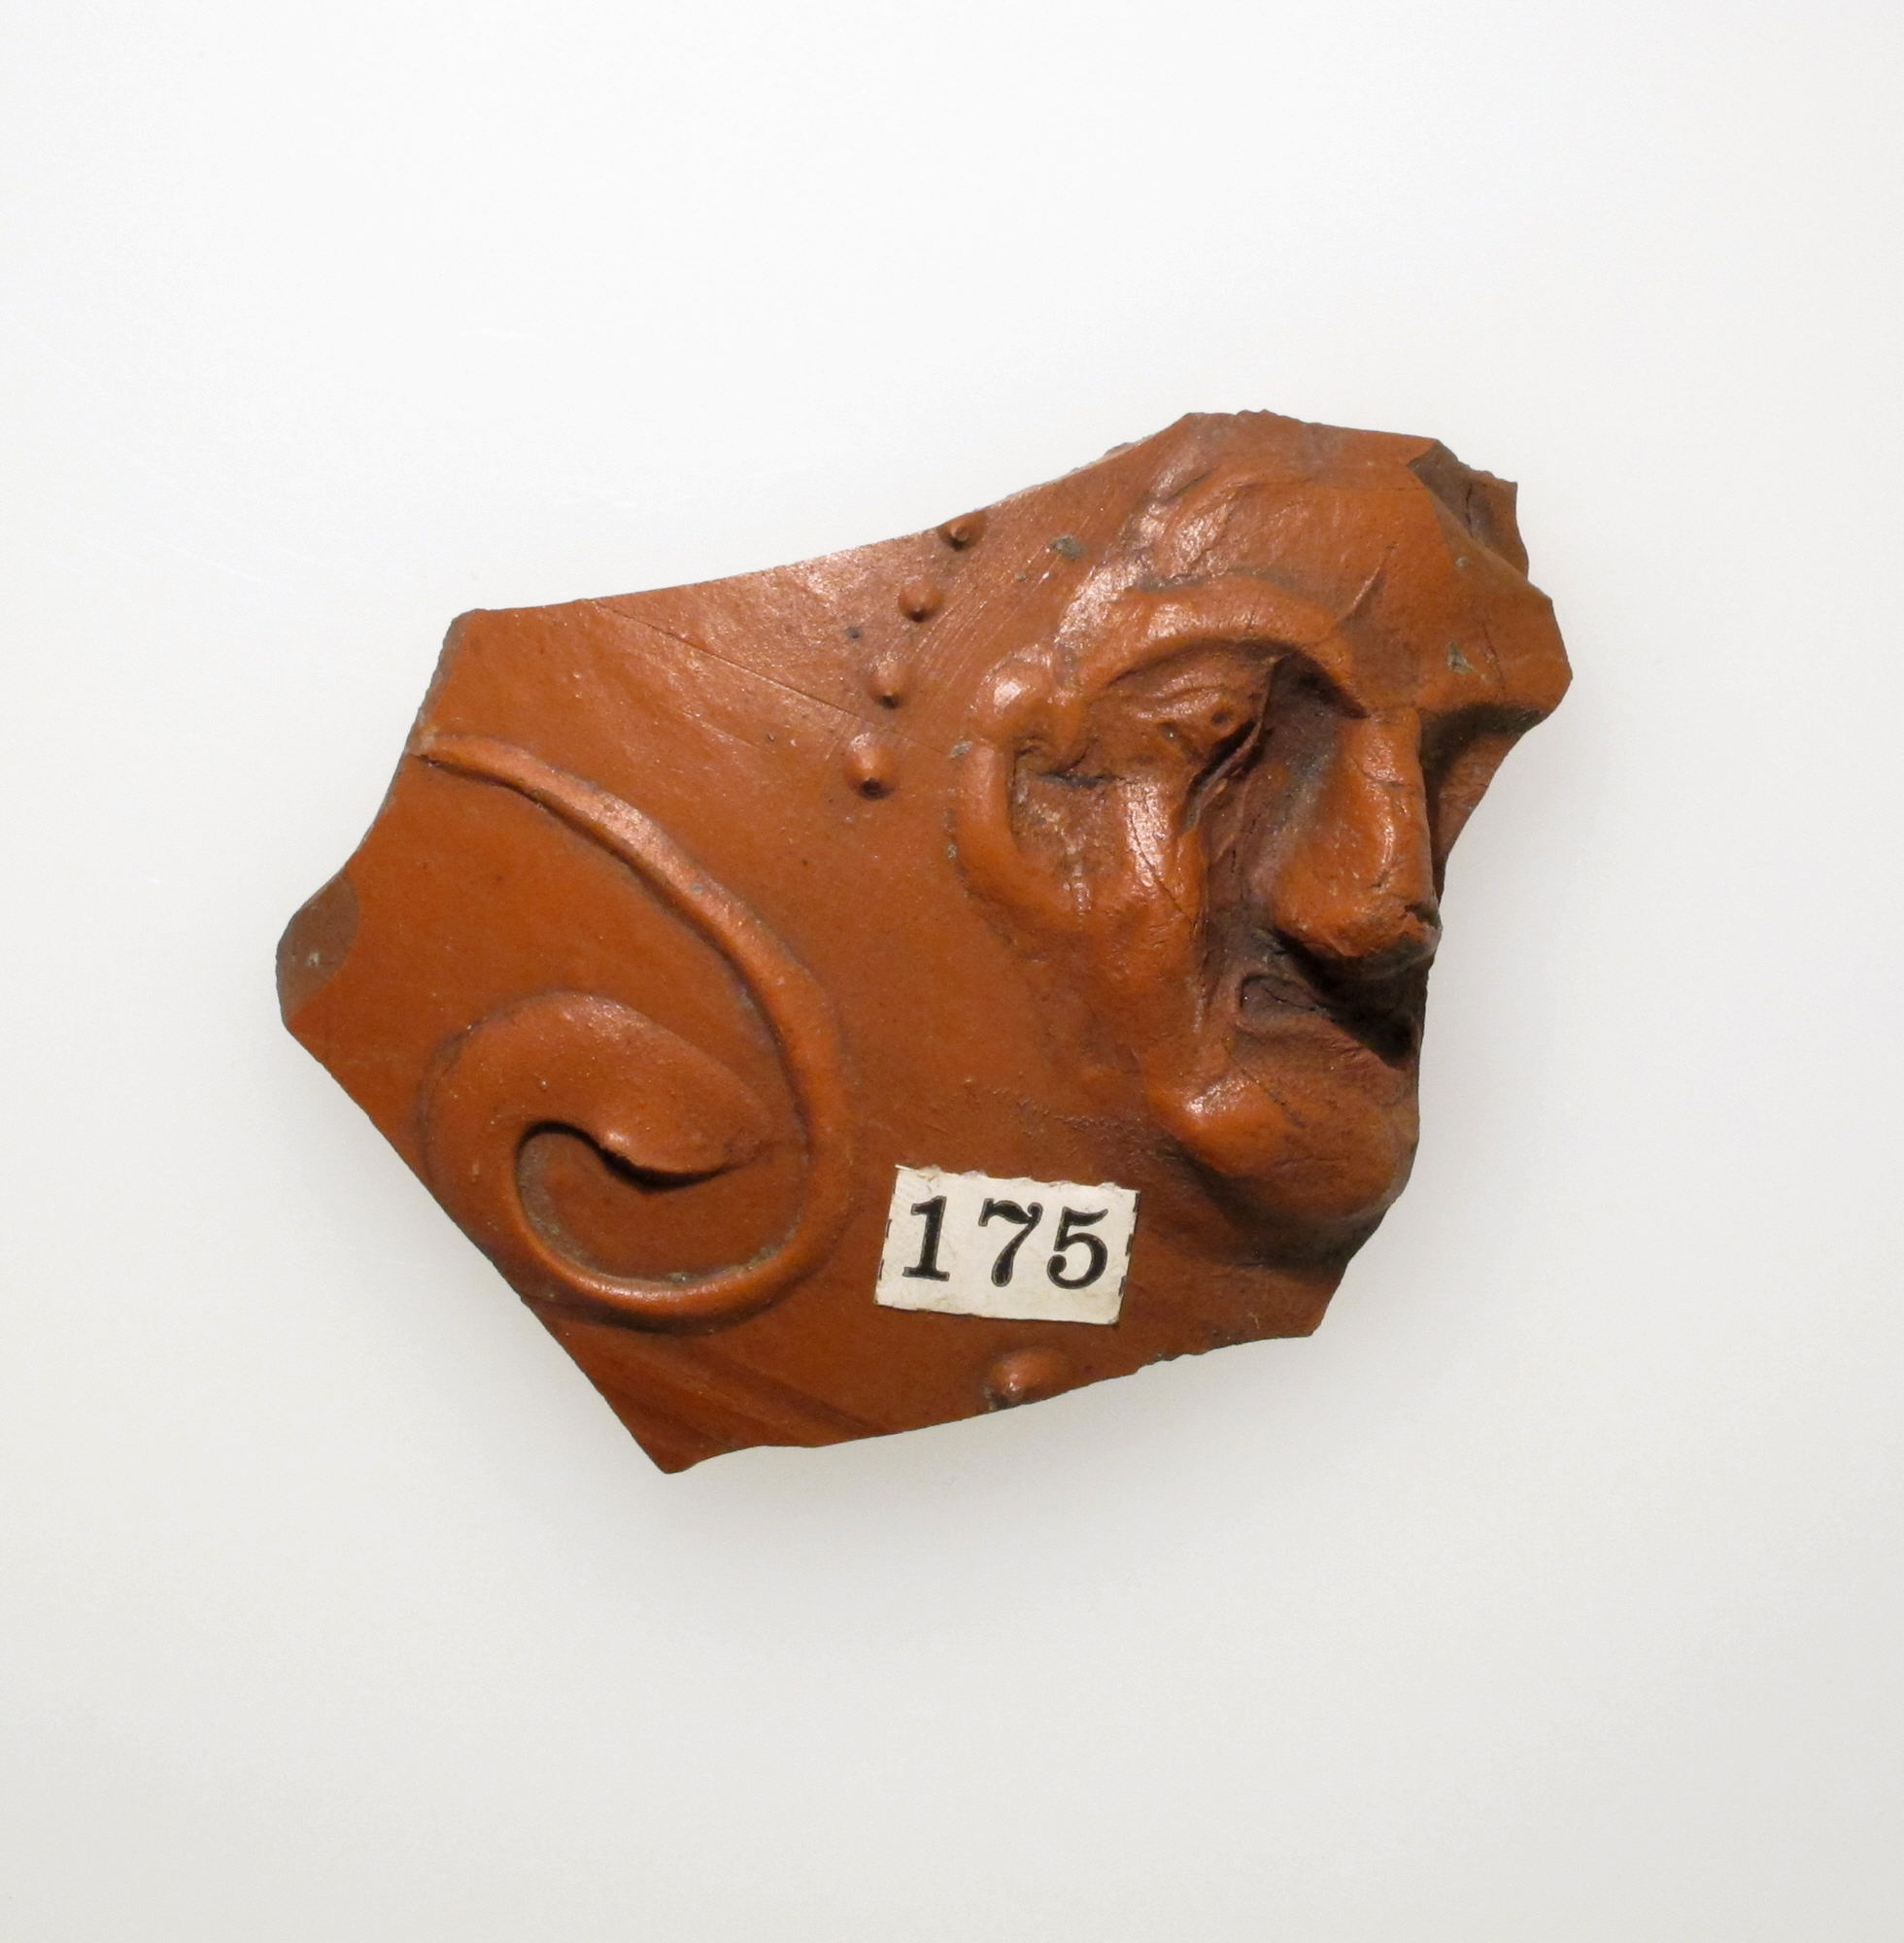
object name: vase fragment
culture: roman, gaul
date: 120 BCE-300 CE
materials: terracotta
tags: faces